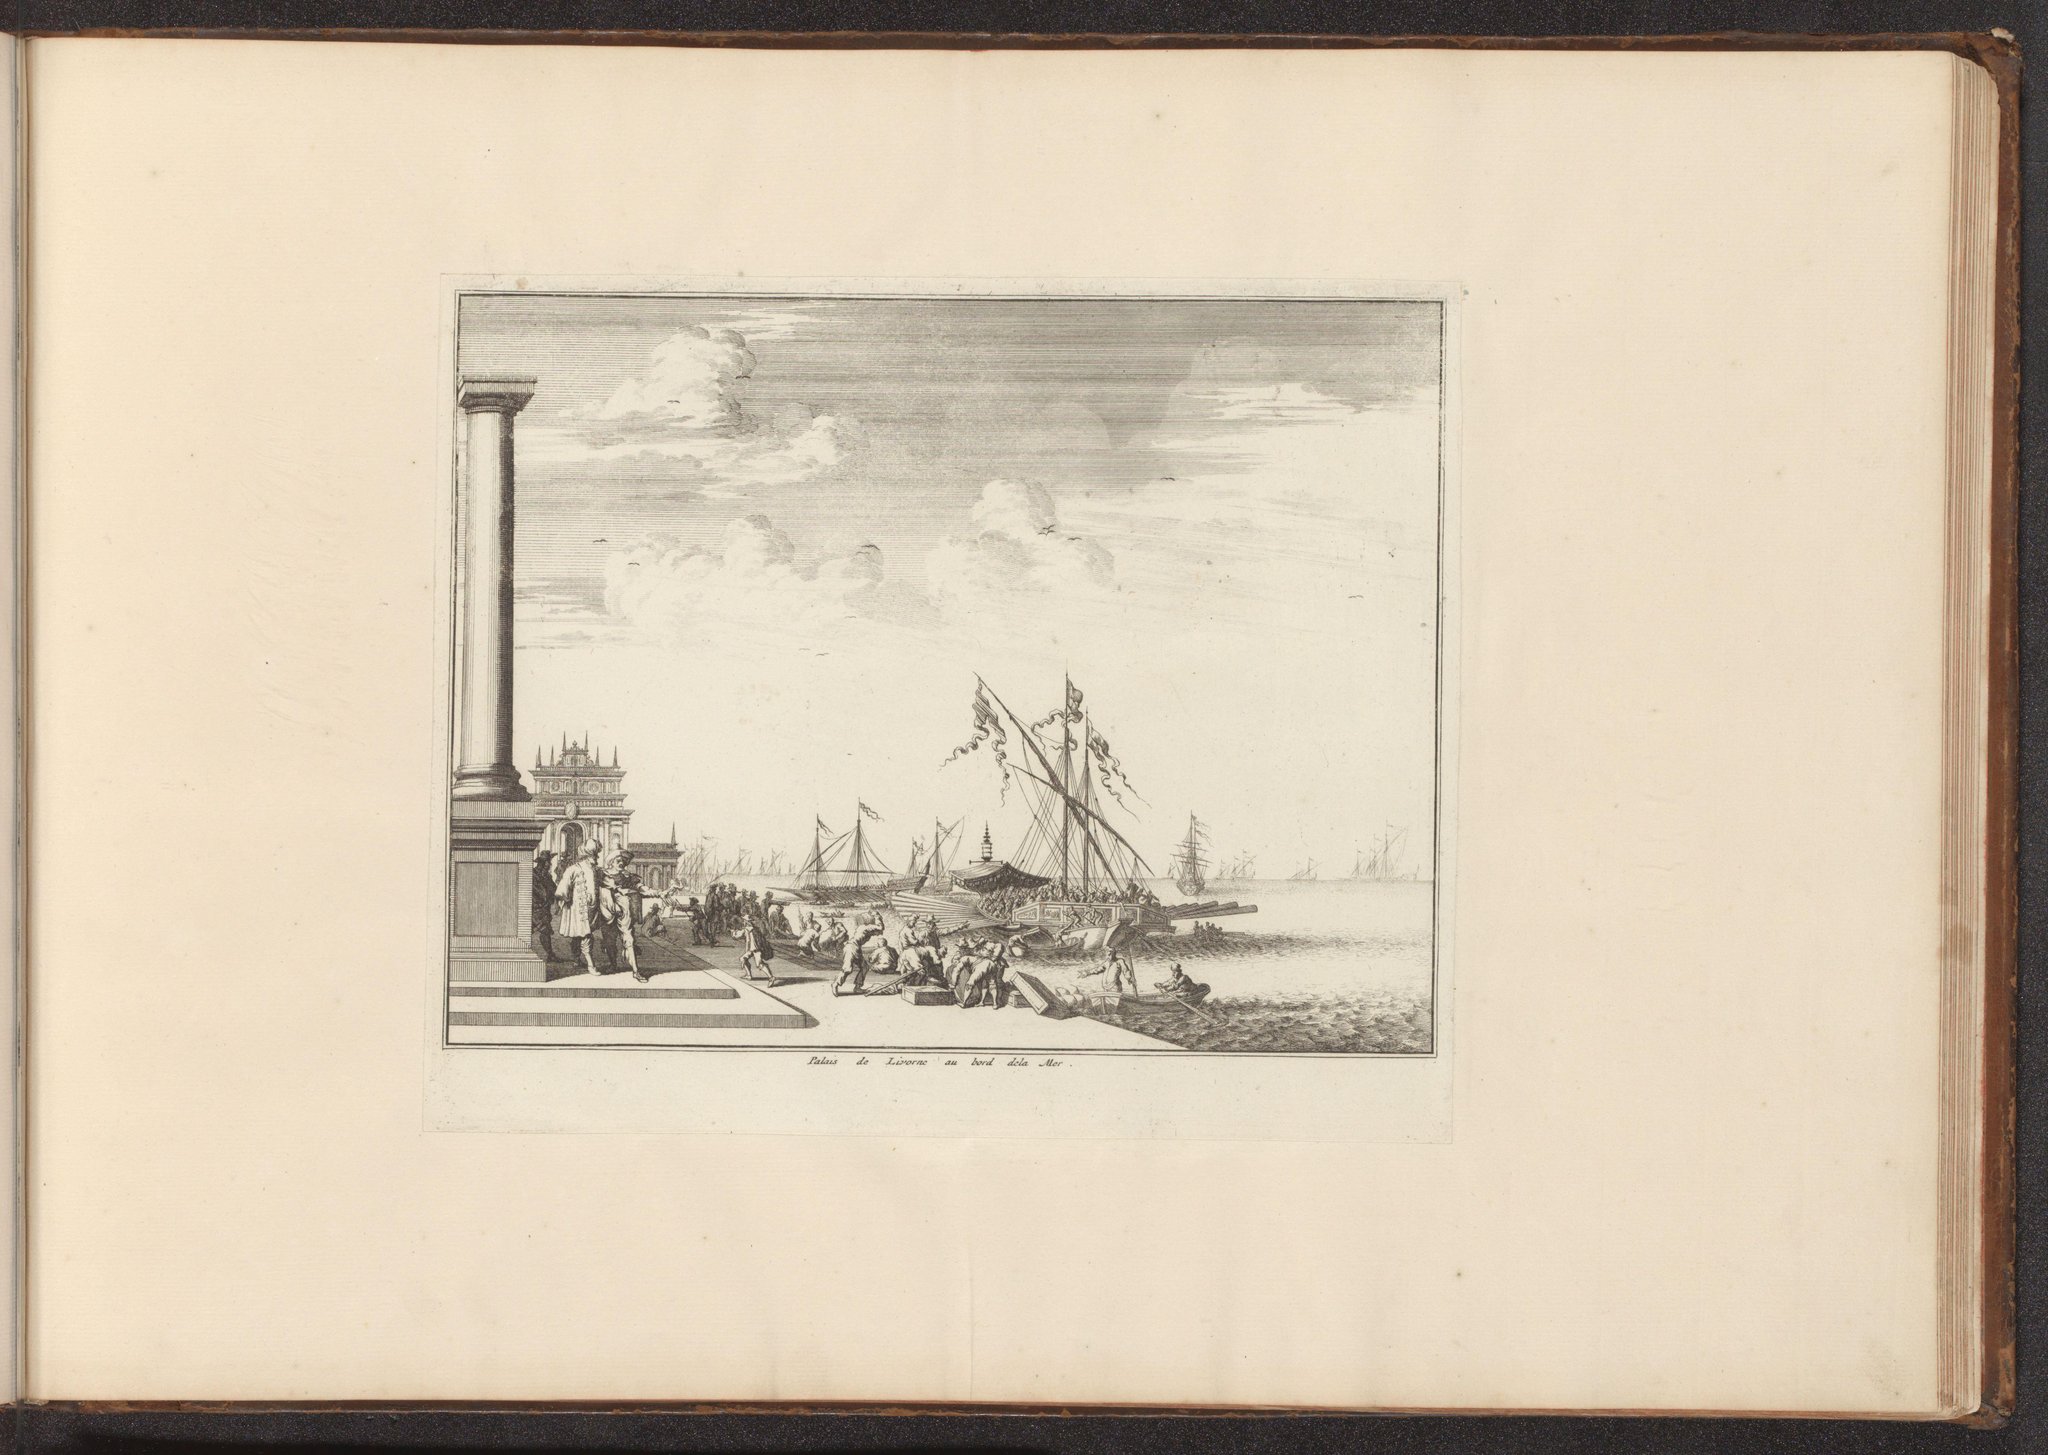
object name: album leaf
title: Gezicht op een paleis in Livorno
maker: Anonymous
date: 1700-1710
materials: paper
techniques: etching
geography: france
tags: hôtel, i.e. small palace in city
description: Gezicht op een paleis aan de waterkant in Livorno. Op het water verschillende schepen. Titel in het Frans in ondermarge. De prent maakt deel uit van een album.